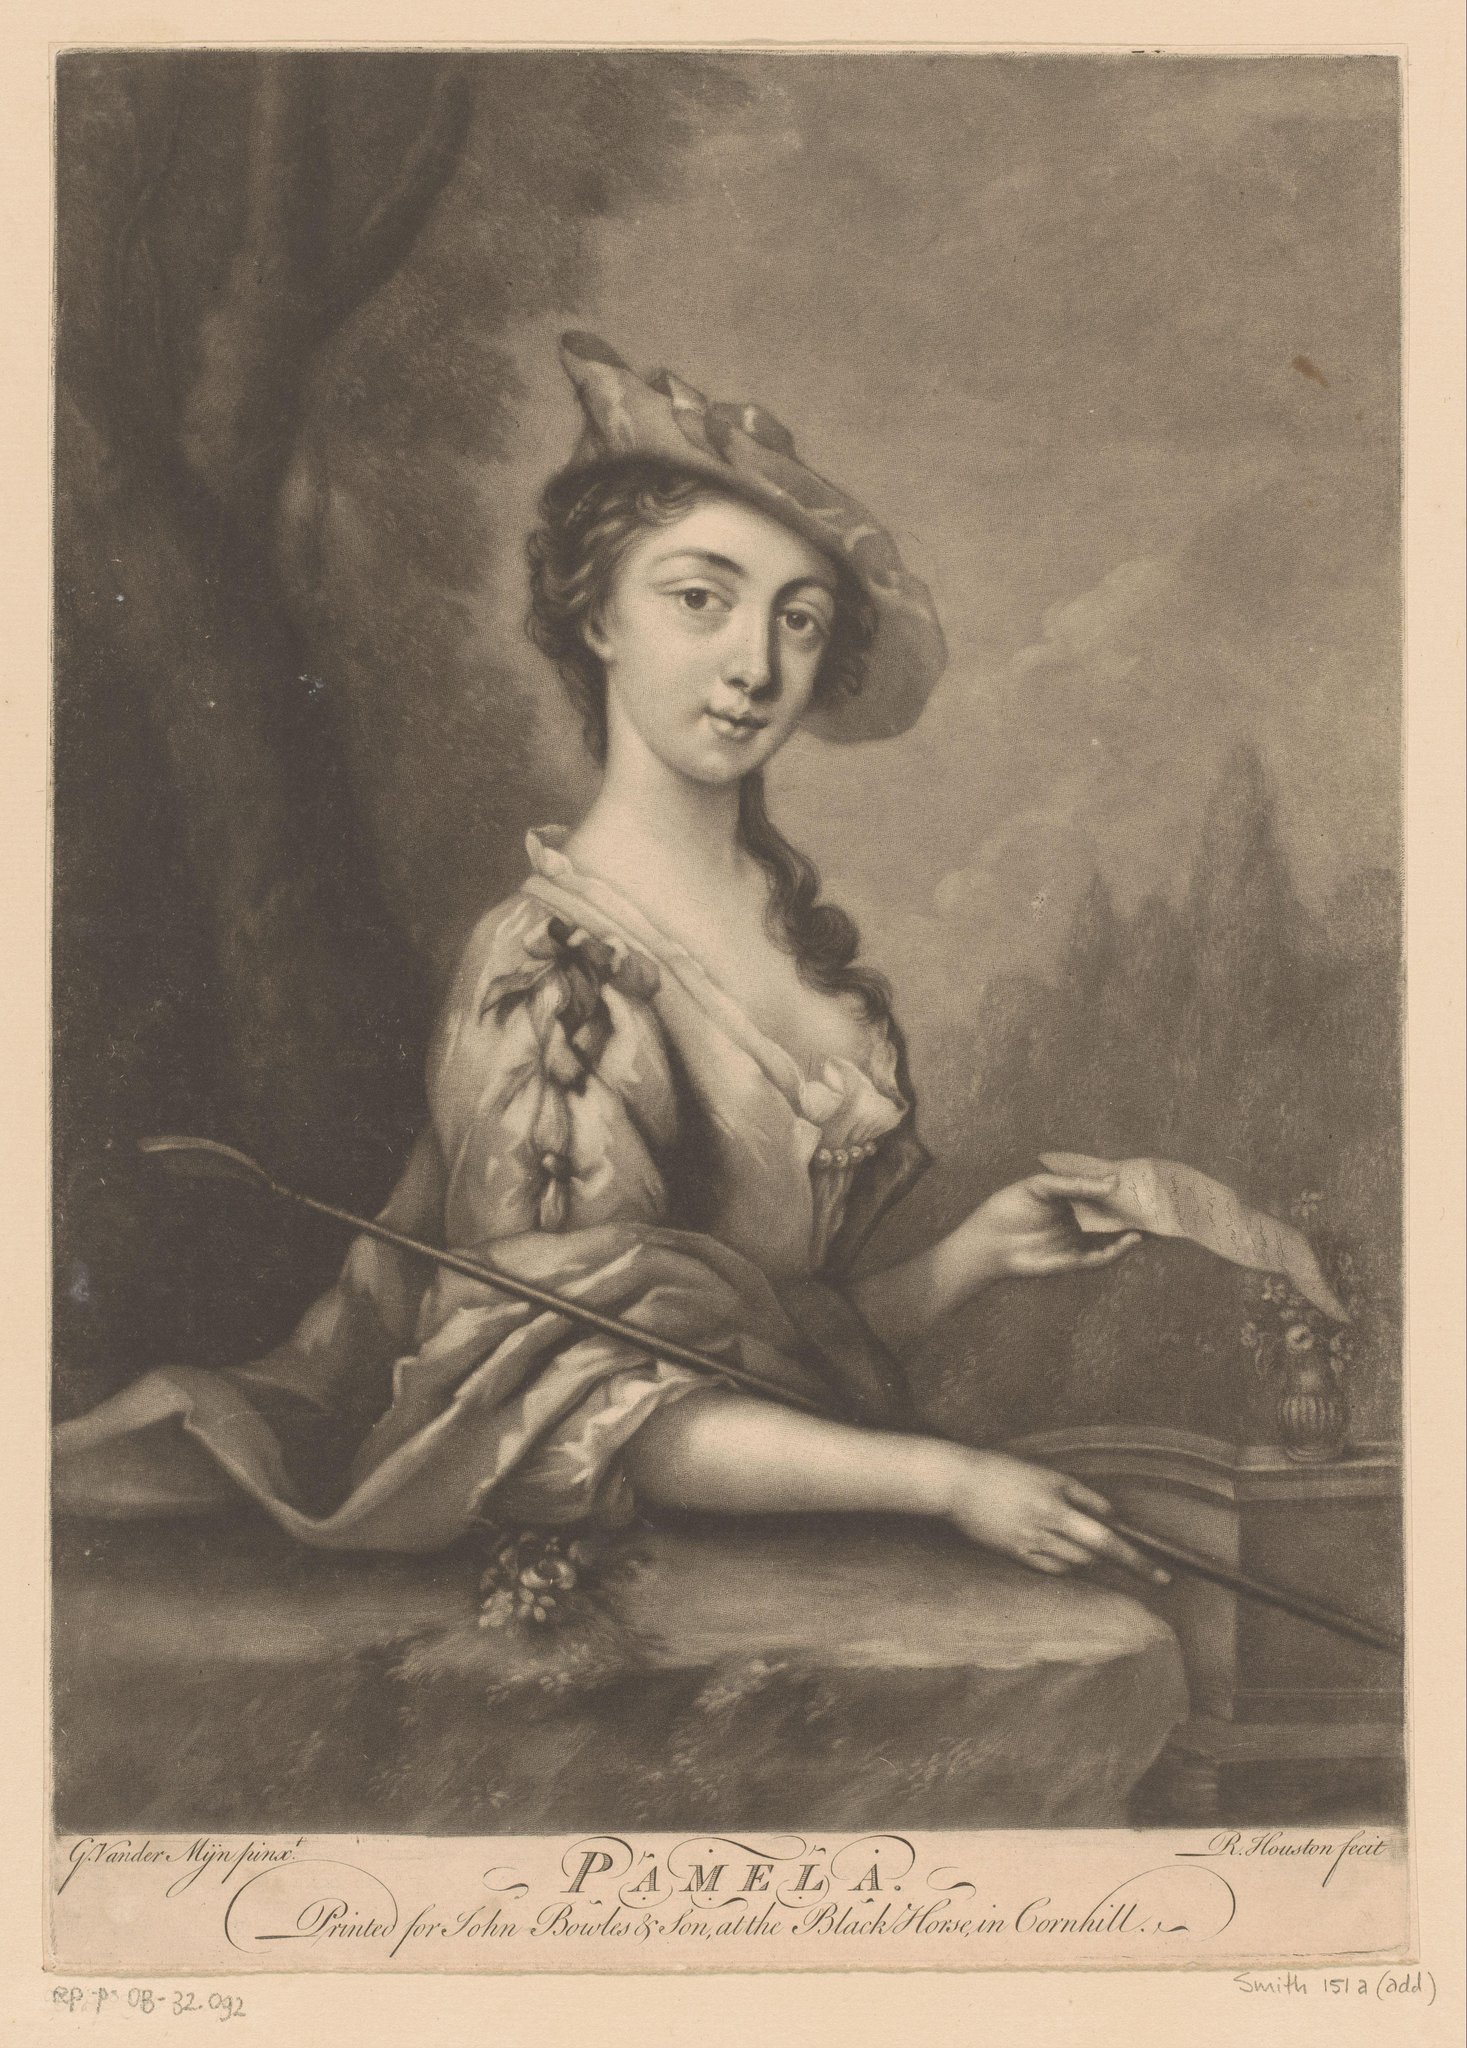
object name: print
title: Portret van een onbekende vrouw, bekend als Pamela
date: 1731-1766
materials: paper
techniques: mezzotint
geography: london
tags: adolescent, young woman, maiden, historical persons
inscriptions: collector's mark: Lugt 240